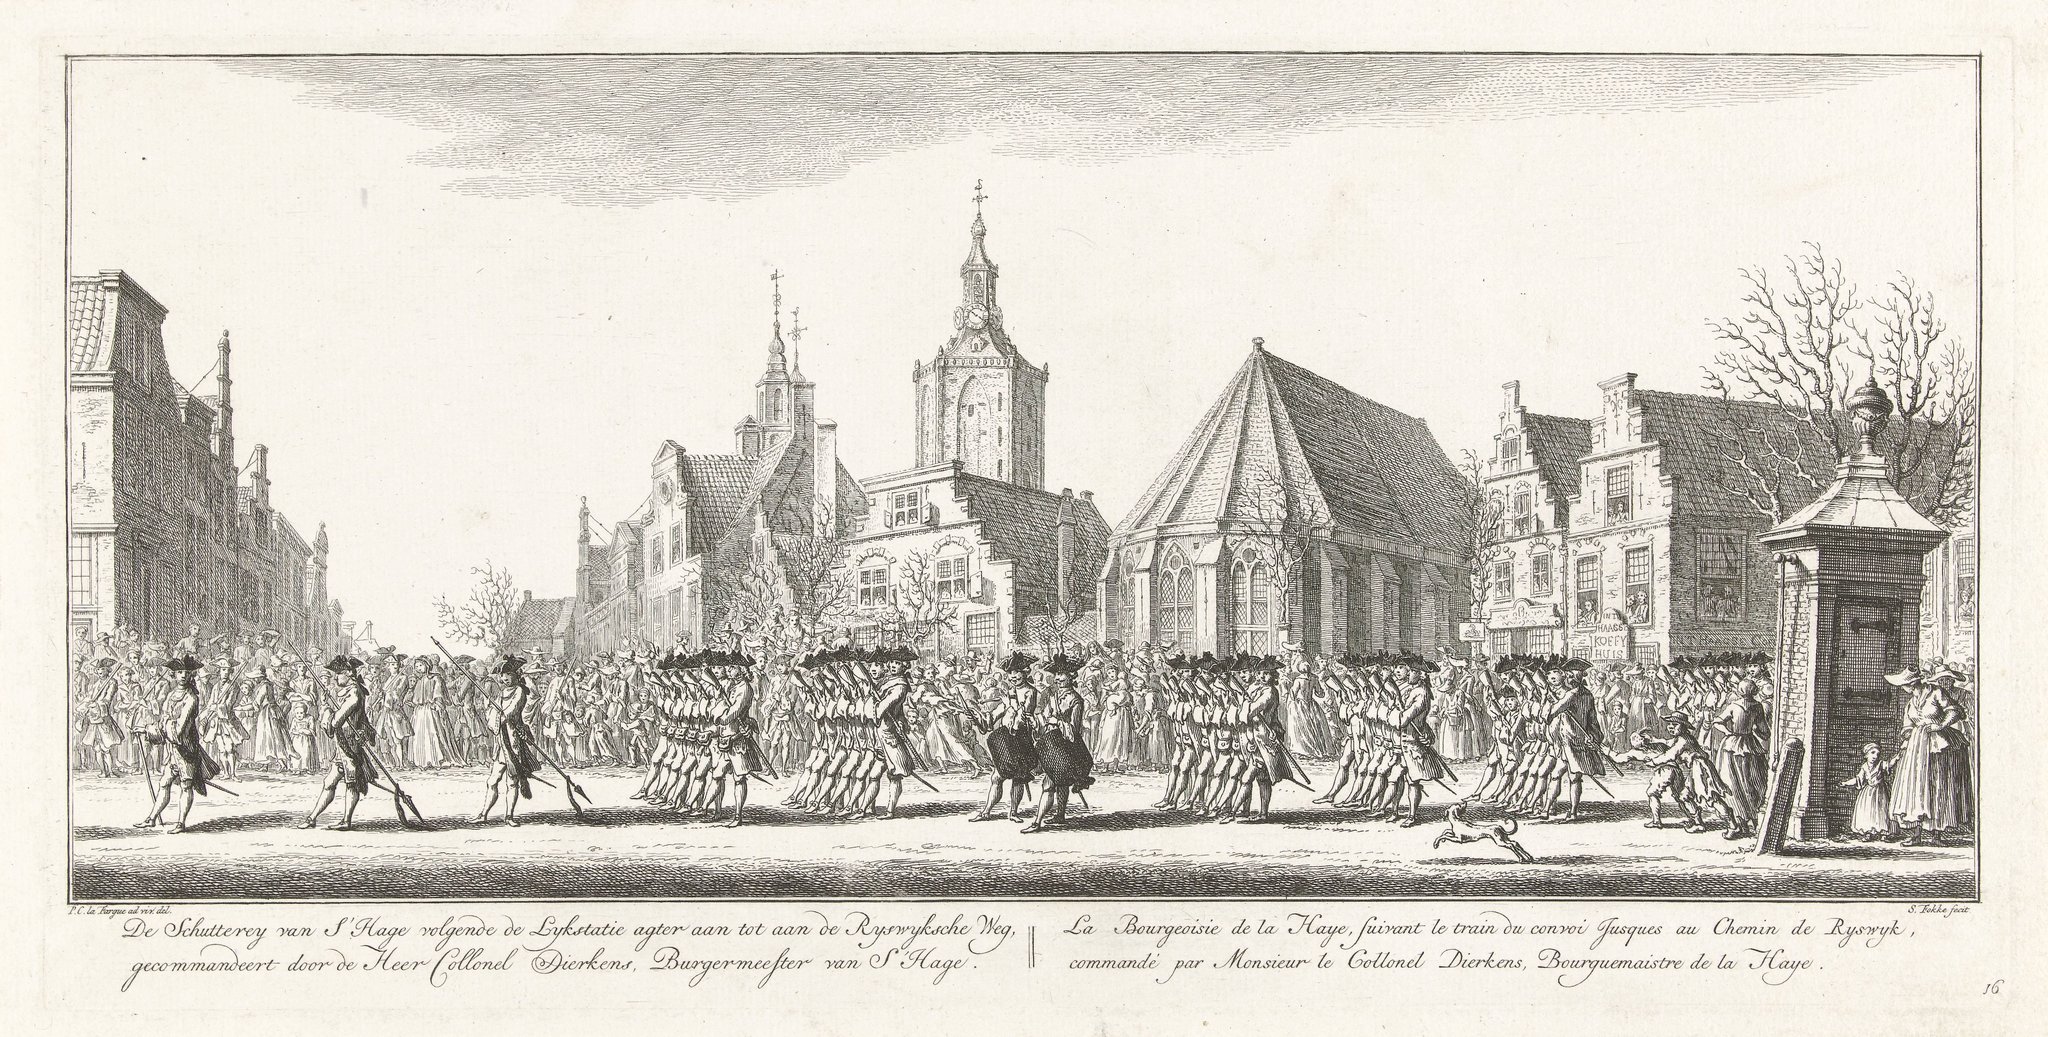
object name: print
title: Lykstatie van Haare Koninklyke Hoogheid Anna, Kroon-princesse van Engeland, Douariere van Willem Carel Hendrik Frisso, Prins van Oranje. Gehouden op Vrydag den 23 February 1759, bygezet te Delft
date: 1759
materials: paper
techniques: engraving, etching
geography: northern netherlands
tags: the hague, anna van hannover, cortege, funeral procession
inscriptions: collector's mark: Lugt 2228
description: Schutterij van Den Haag, op de achtergrond de Grote of Sint-Jacobskerk te Den Haag. Onderdeel van een serie van 16 platen plus een gedrukte beschrijving van de lijkstatie van de op 23 februari 1759 te Delft begraven prinses Anna van Hannover. Genummerd rechtsonder: 16.